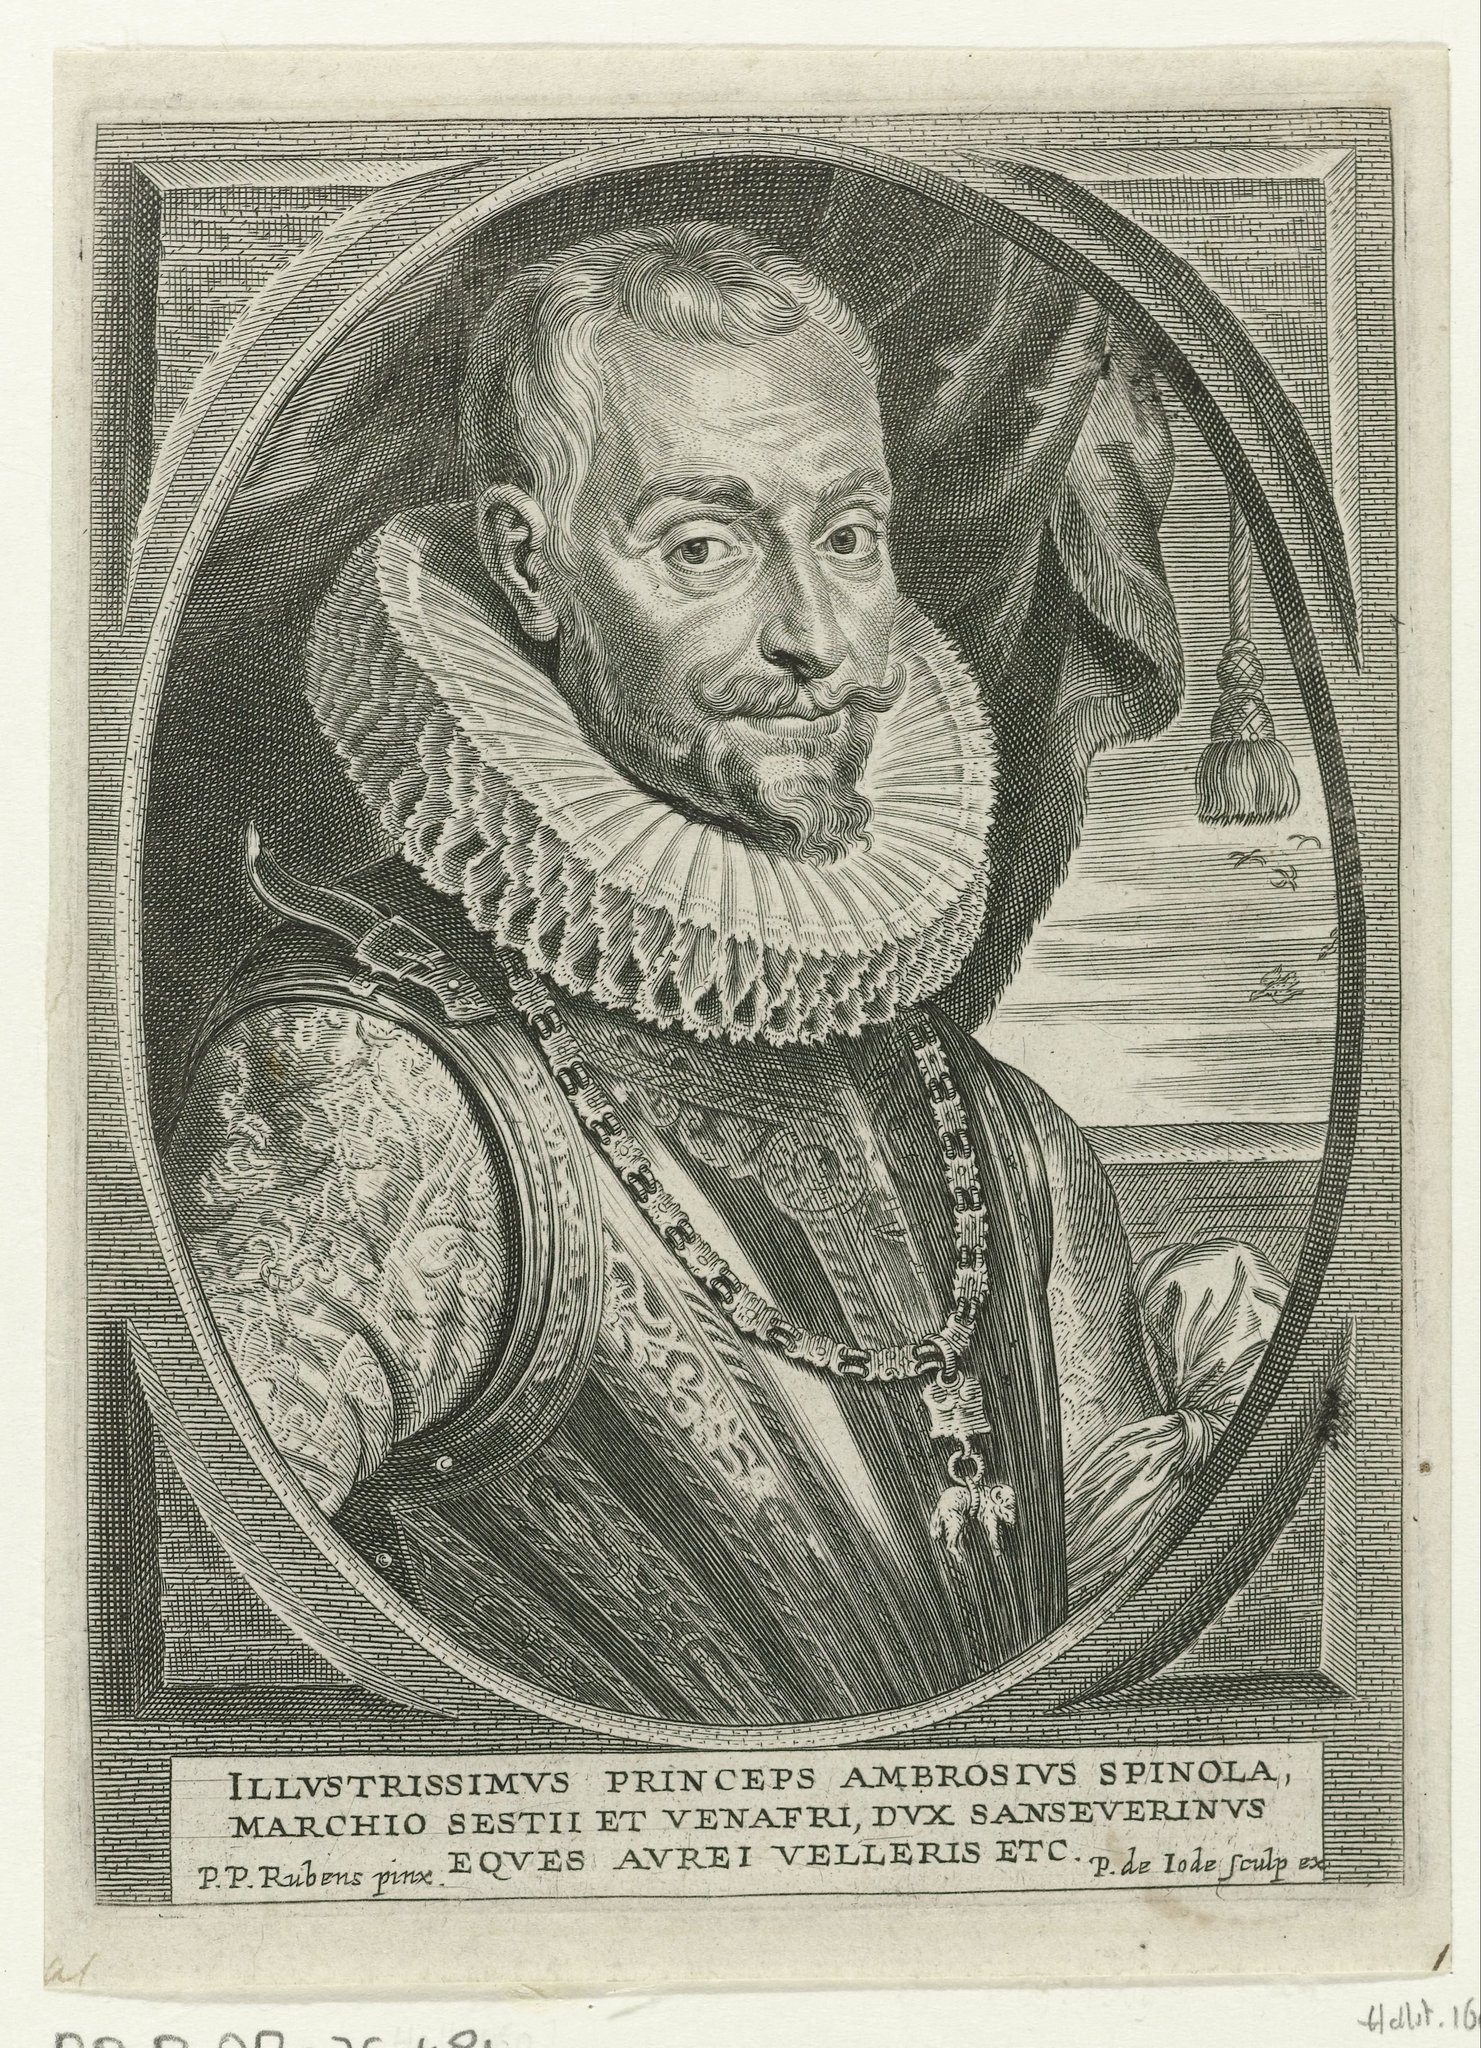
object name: print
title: Theatrum pontificum, imperatorum, regum, ducum, principum, etc.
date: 1628-1670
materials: paper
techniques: engraving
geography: antwerp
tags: armour, knighthood order of the golden fleece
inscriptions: collector's mark: Lugt 240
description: Busteportret van Ambrogio Spinola, in harnas. Hij draagt een keten met de Orde van het Gulden Vlies en een strik om zijn linkerarm. Het portret is gevat in een ovale omlijsting met vierkant randwerk. In het kader een drieregelig onderschrift in het Latijn.